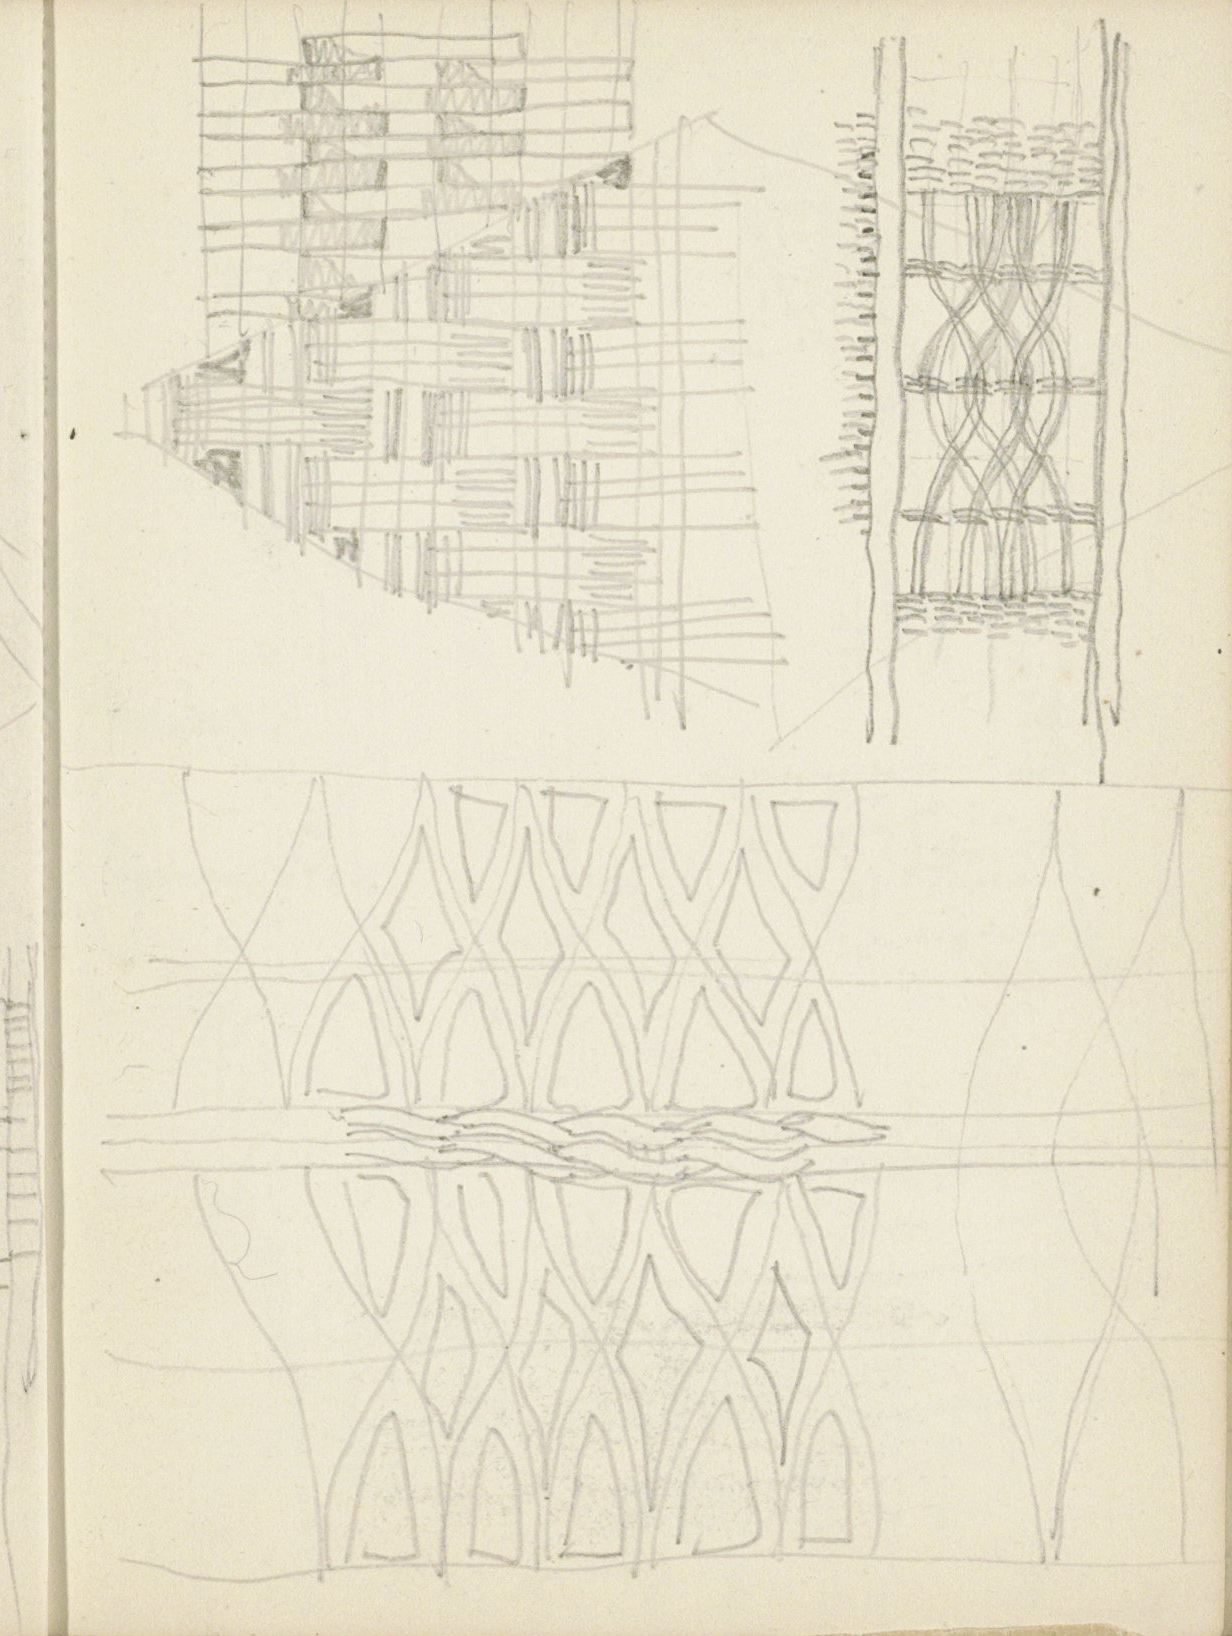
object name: sketchbook leaf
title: Decoratieve weefpatronen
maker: reijer stolk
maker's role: draughtsman, print maker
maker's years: 1896-1945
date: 1916-1945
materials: paper, pencil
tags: weaving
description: Blad 13 recto uit een schetsboek met 60 bladen.